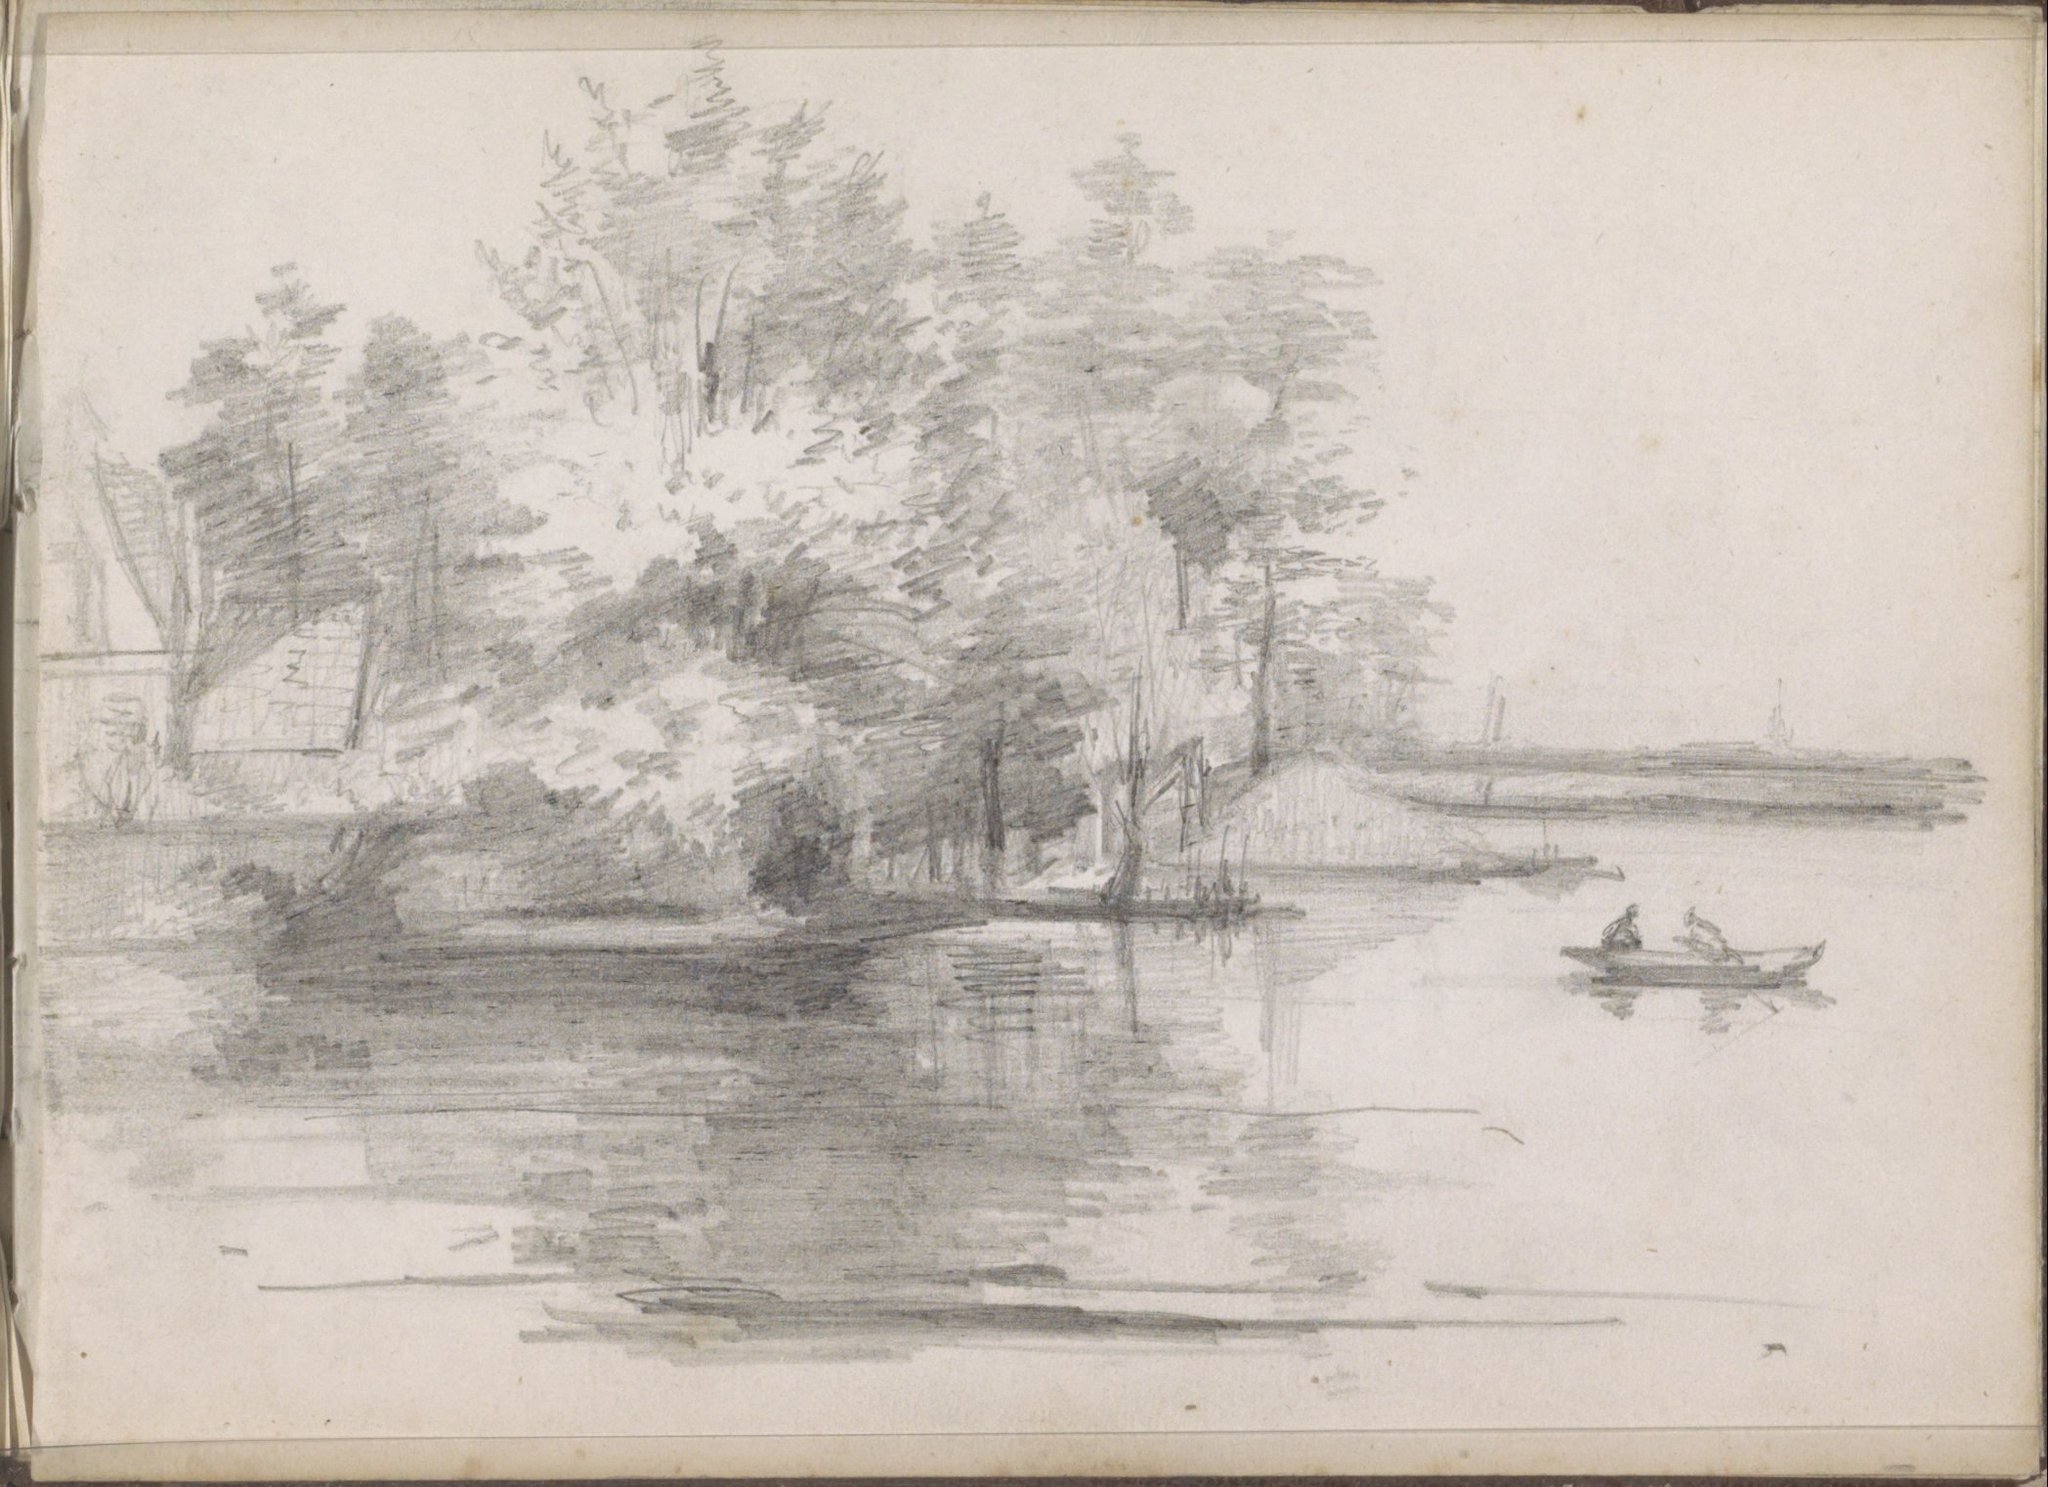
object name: sketchbook leaf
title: Roeiboot met figuren op een rivier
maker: maria vos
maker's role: draughtsman, painter, print maker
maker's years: 1824-1906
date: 1834-1906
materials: paper, pencil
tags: river, rowing-boat, canoe, etc.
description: Blad 29 recto uit een schetsboek met 30 bladen.